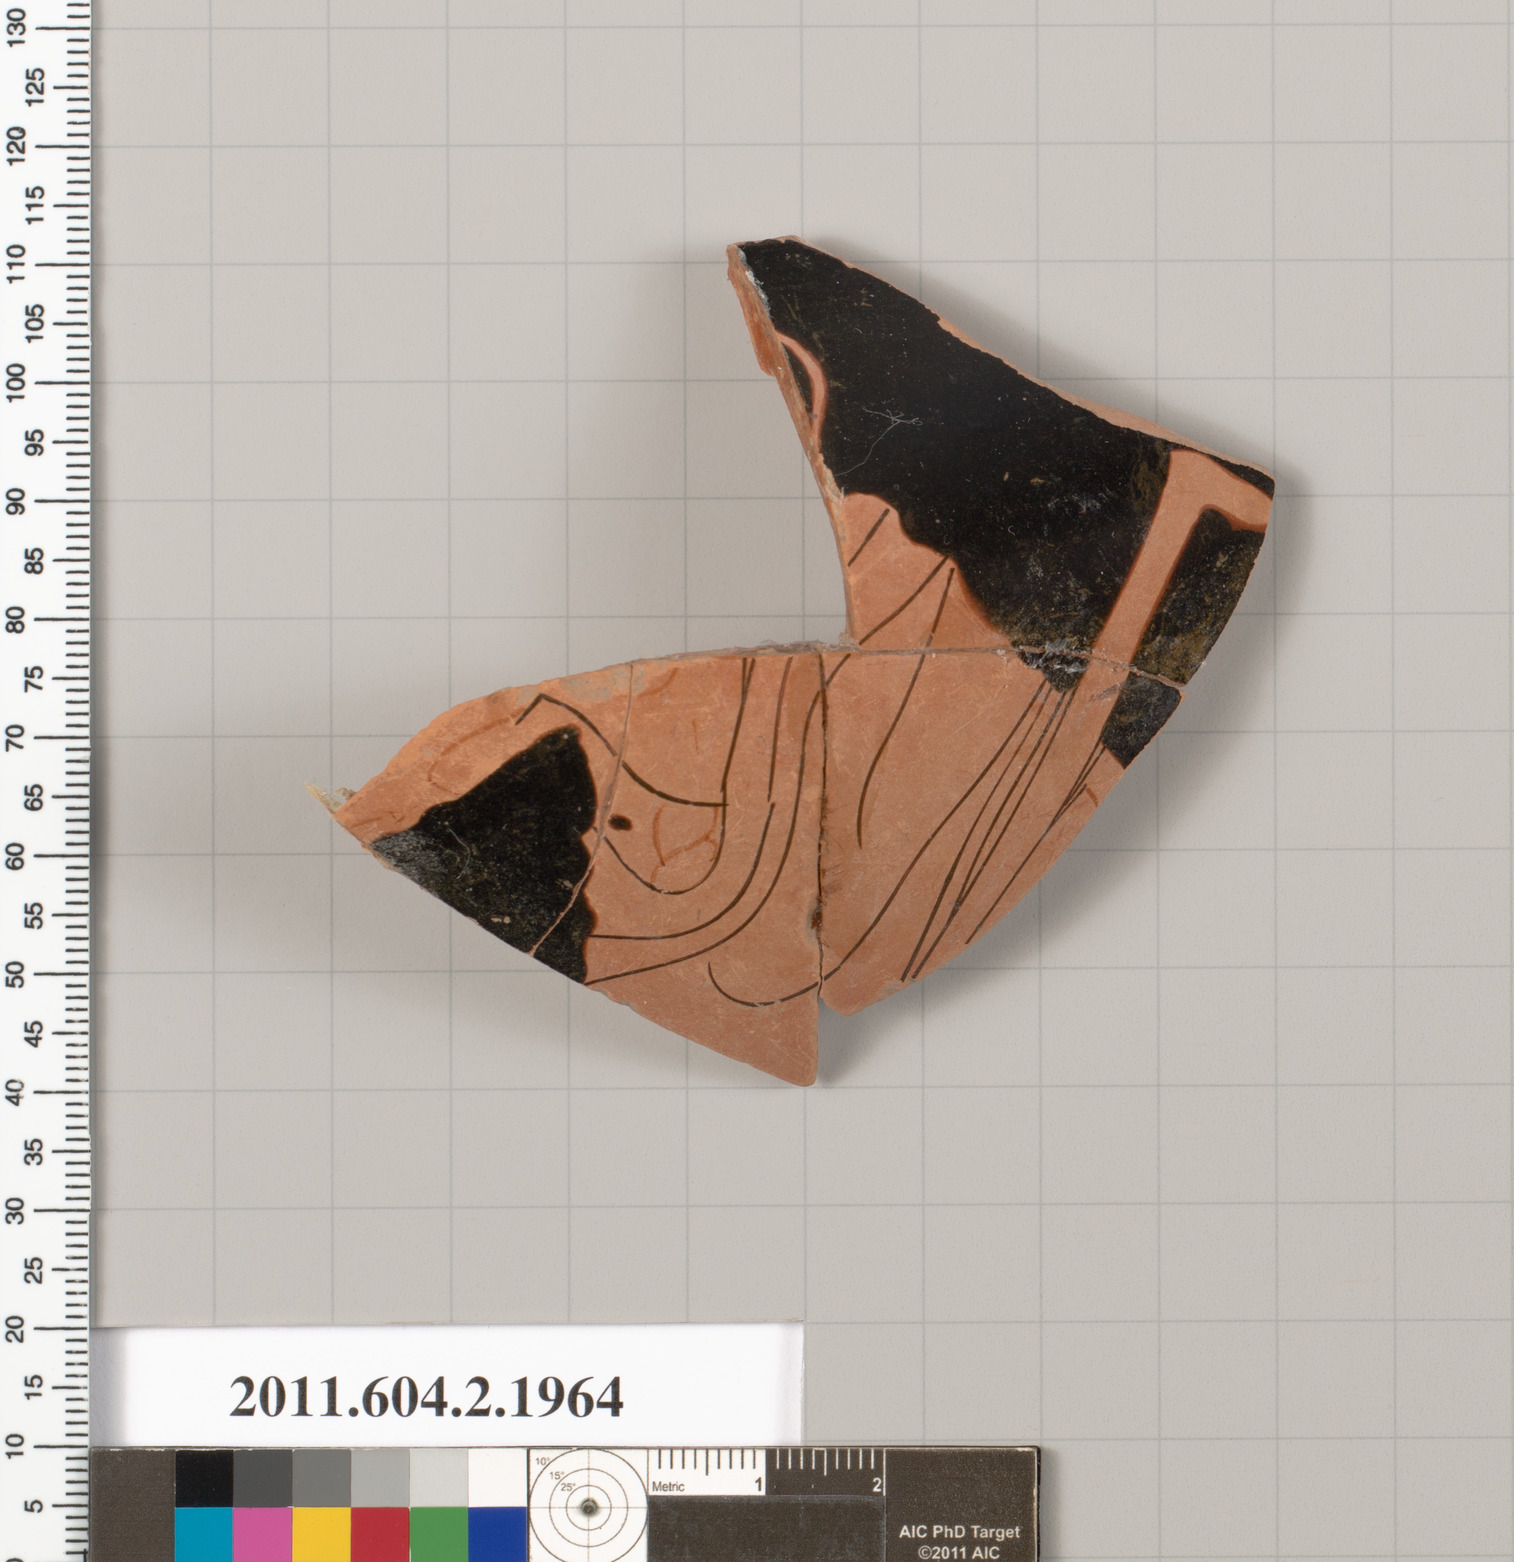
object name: neck amphora fragment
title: Terracotta fragment of a Nolan neck-amphora (jar)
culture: greek, attic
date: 475-451 BCE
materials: terracotta